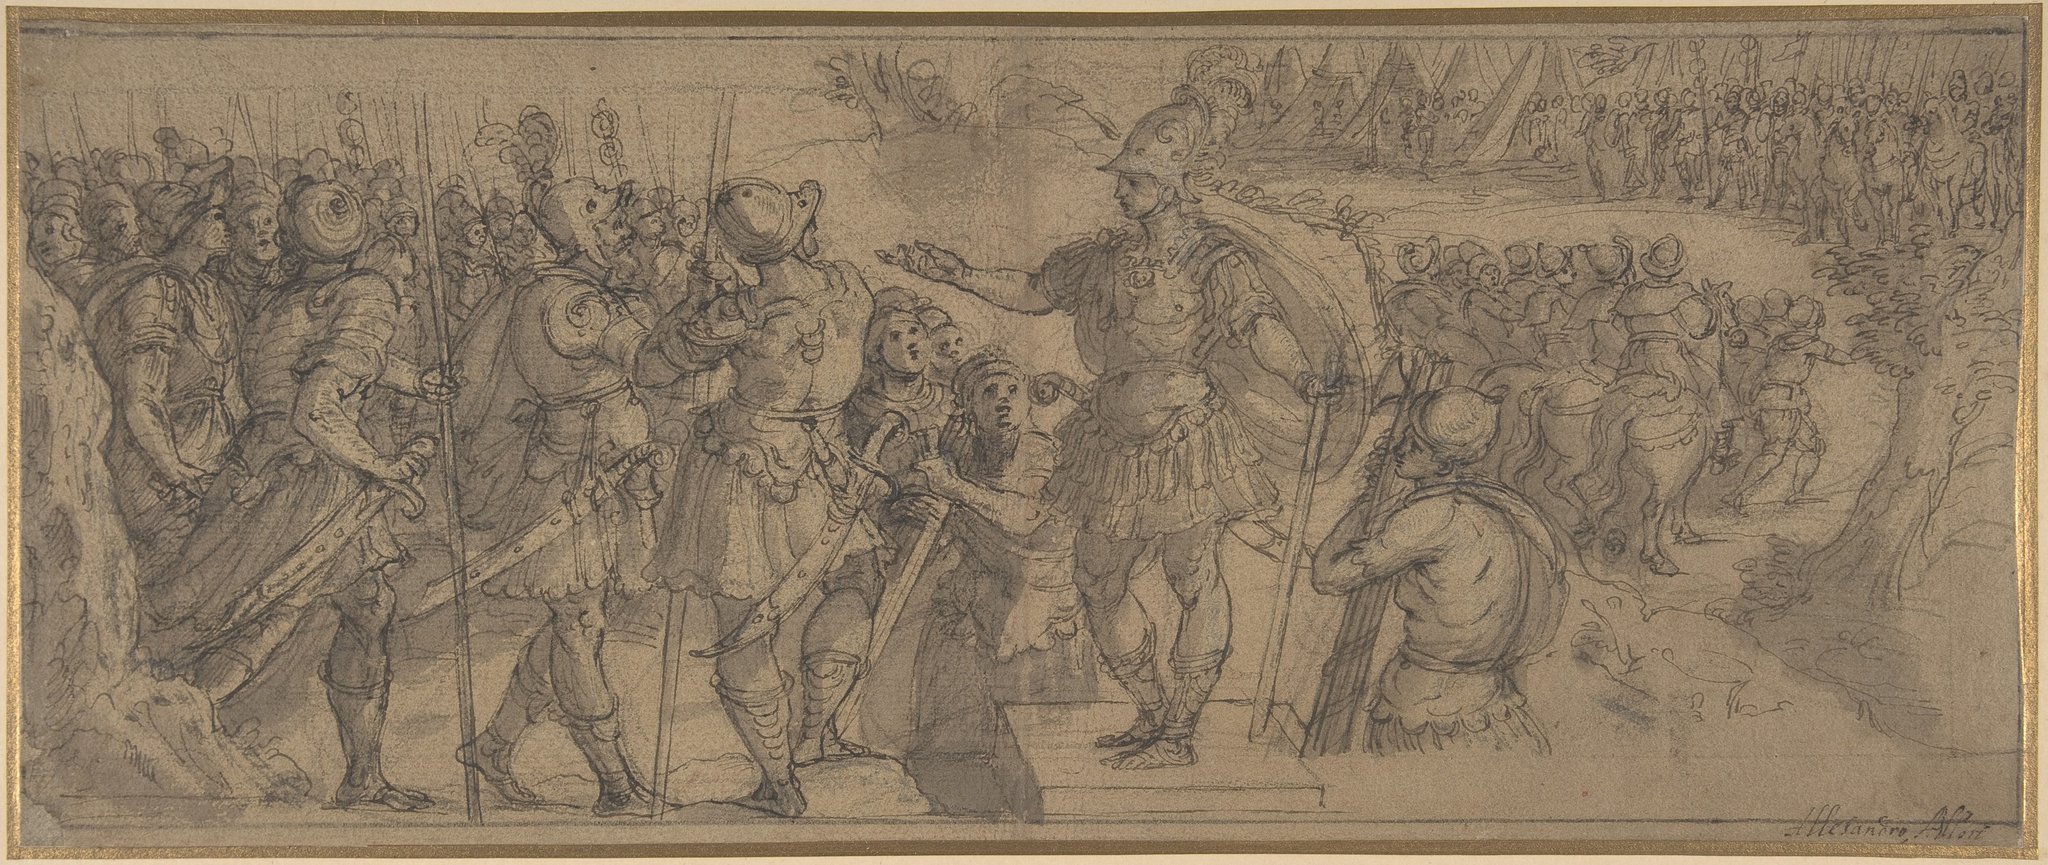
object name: drawing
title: Design for a Narrative Frieze: A Commander Addressing His Troops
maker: alessandro allori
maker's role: artist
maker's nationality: italian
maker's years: 1535-1607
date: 1535-1607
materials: chalk, ink, paper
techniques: brush, highlighting, pen, wash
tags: battles,soldiers,weapons,horses